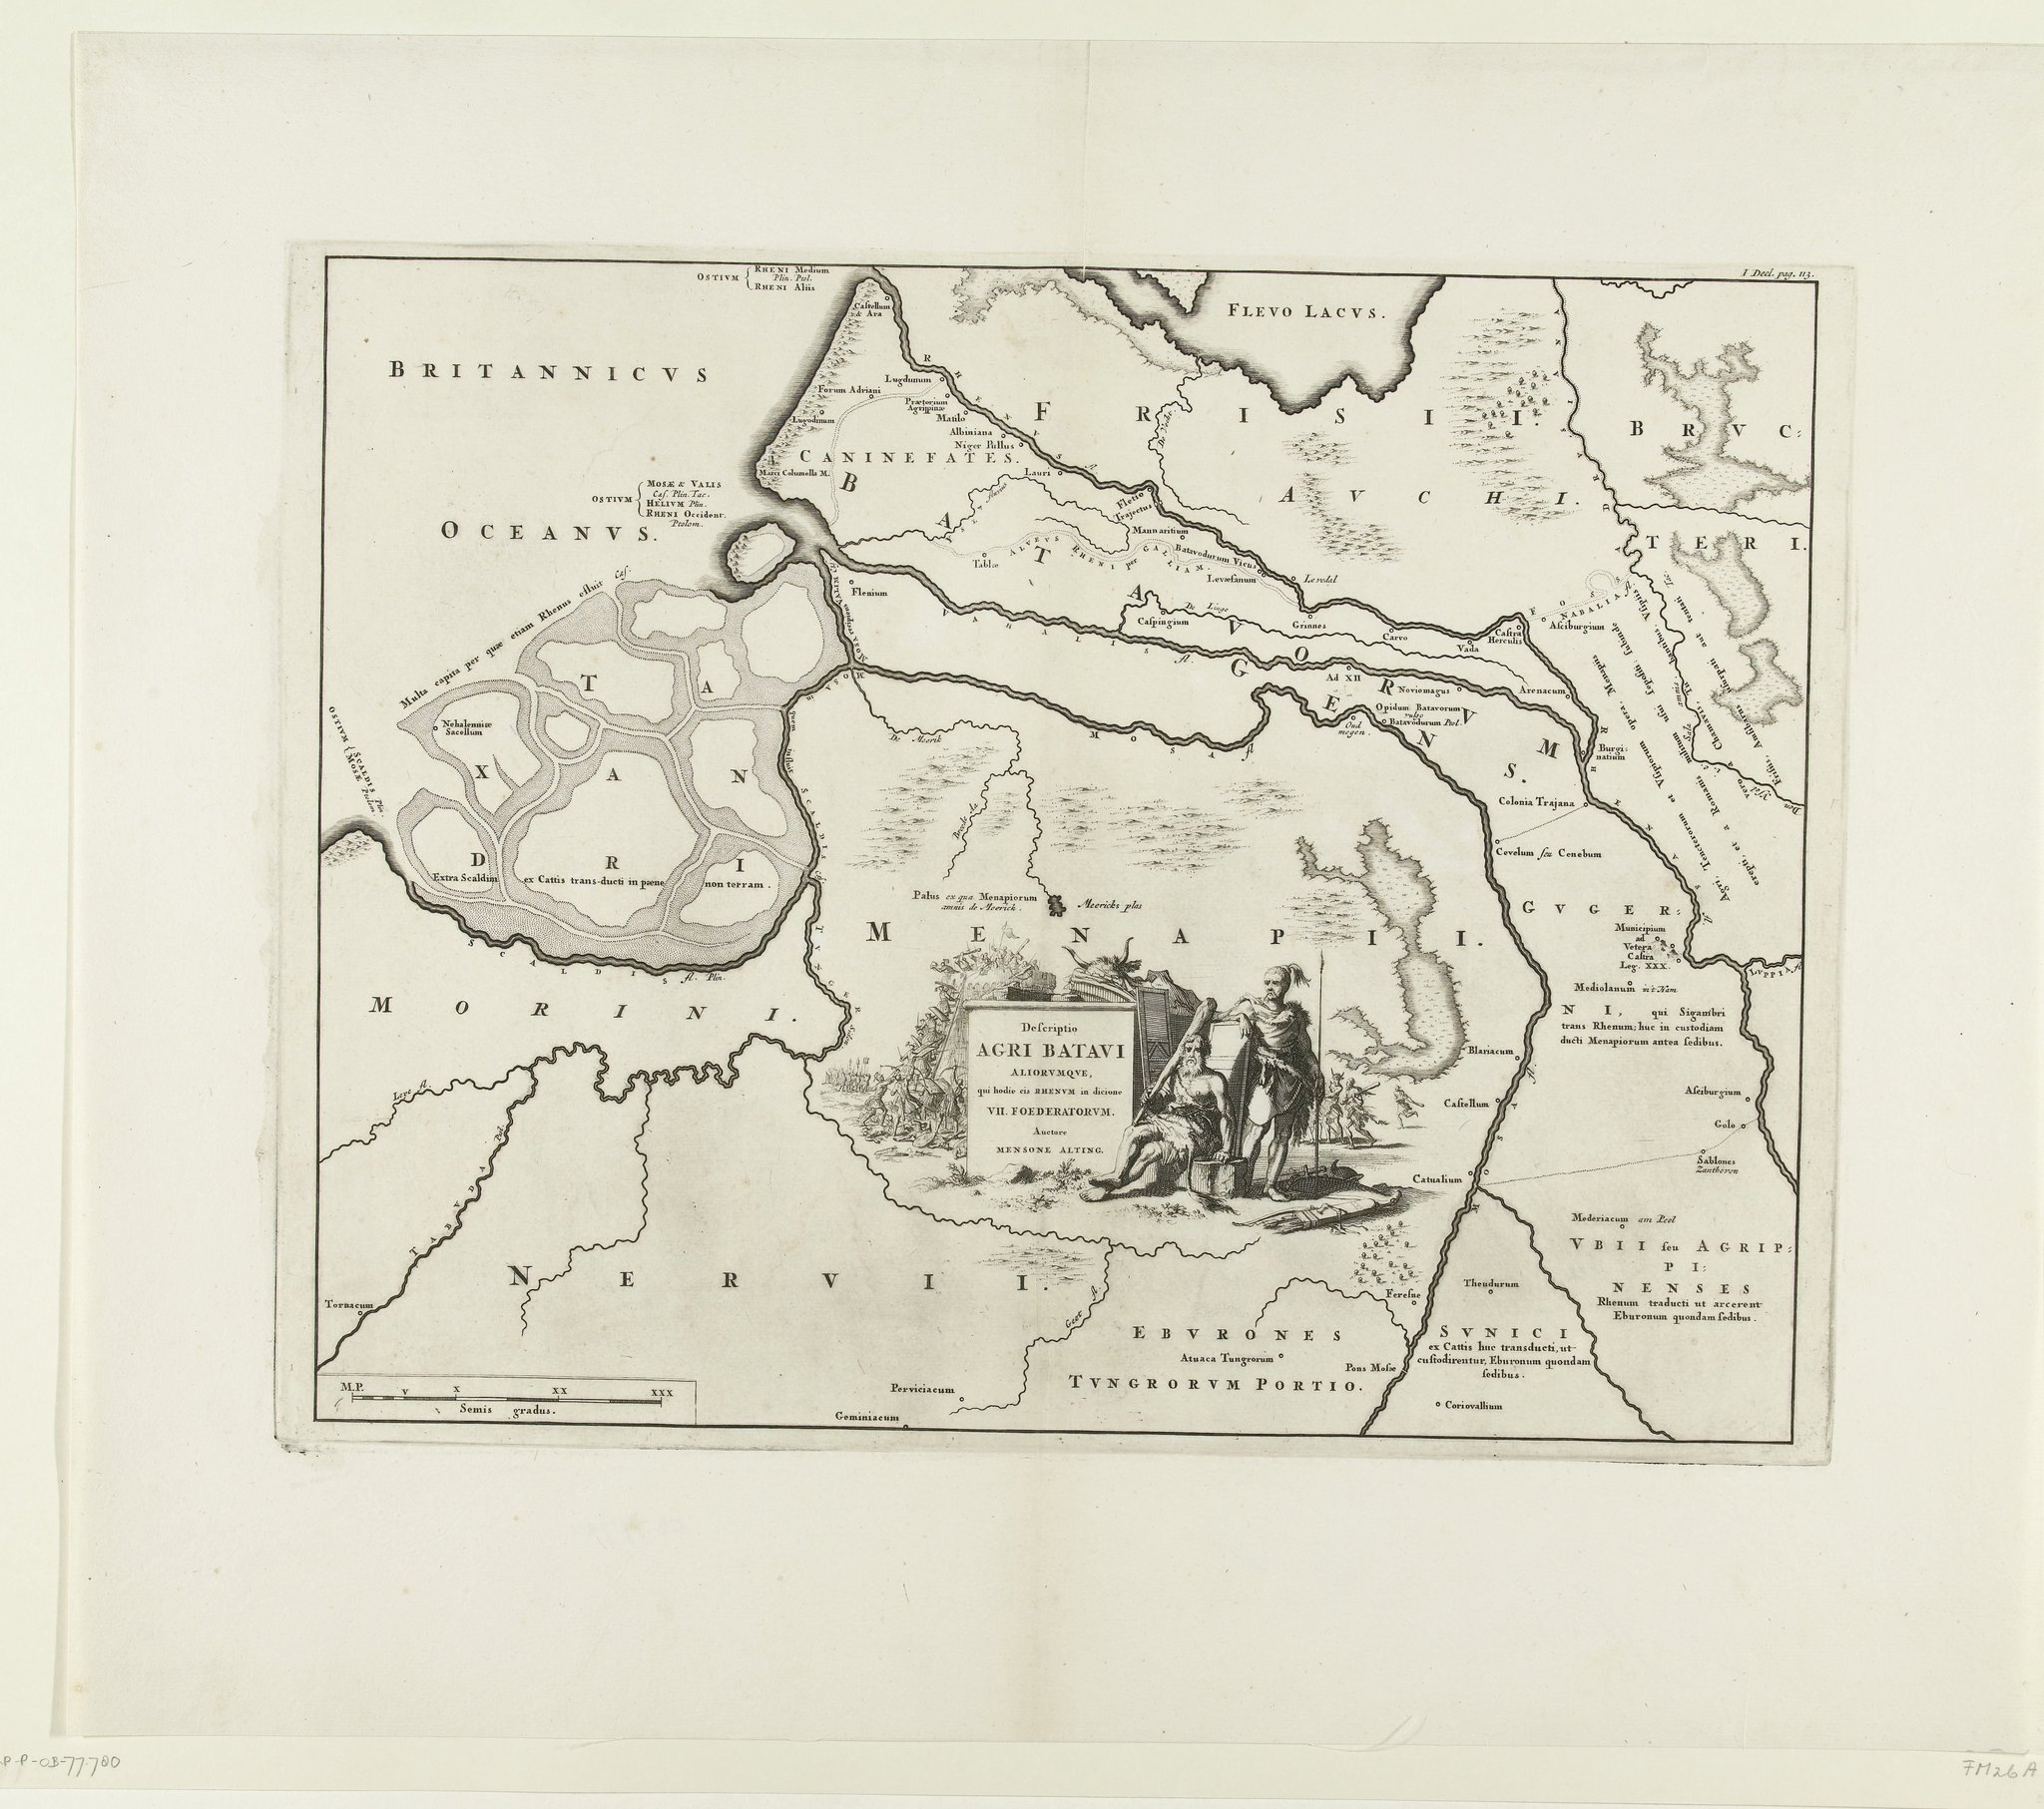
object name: print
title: Descriptio Agri Batavi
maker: jan luyken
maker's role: draughtsman, print maker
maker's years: 1649-1712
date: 1695-1700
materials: paper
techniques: engraving, etching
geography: netherlands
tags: maps of separate countries or regions, netherlands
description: Kaart van het oude Nederland van de Bataven. Maakt deel uit van 16 kaarten van het land van de Bataven en de Friezen eerst vervaardigd voor en opgenomen in M. Alting, Descriptio ant. agri Batavi et Frisii, s. notitia Germ. infer., 2 delen, 1697-1700. Hergebruikt in F. Halma, Tooneel der Vereenigde Nederlanden en onderhorige landschappen, geopent in een algemeen historisch, genealogisch, geographisch en staatkundig woordenboek, 2 delen, 1725. Volgens opschrift geplaatst in: Deel I, pag. 113.